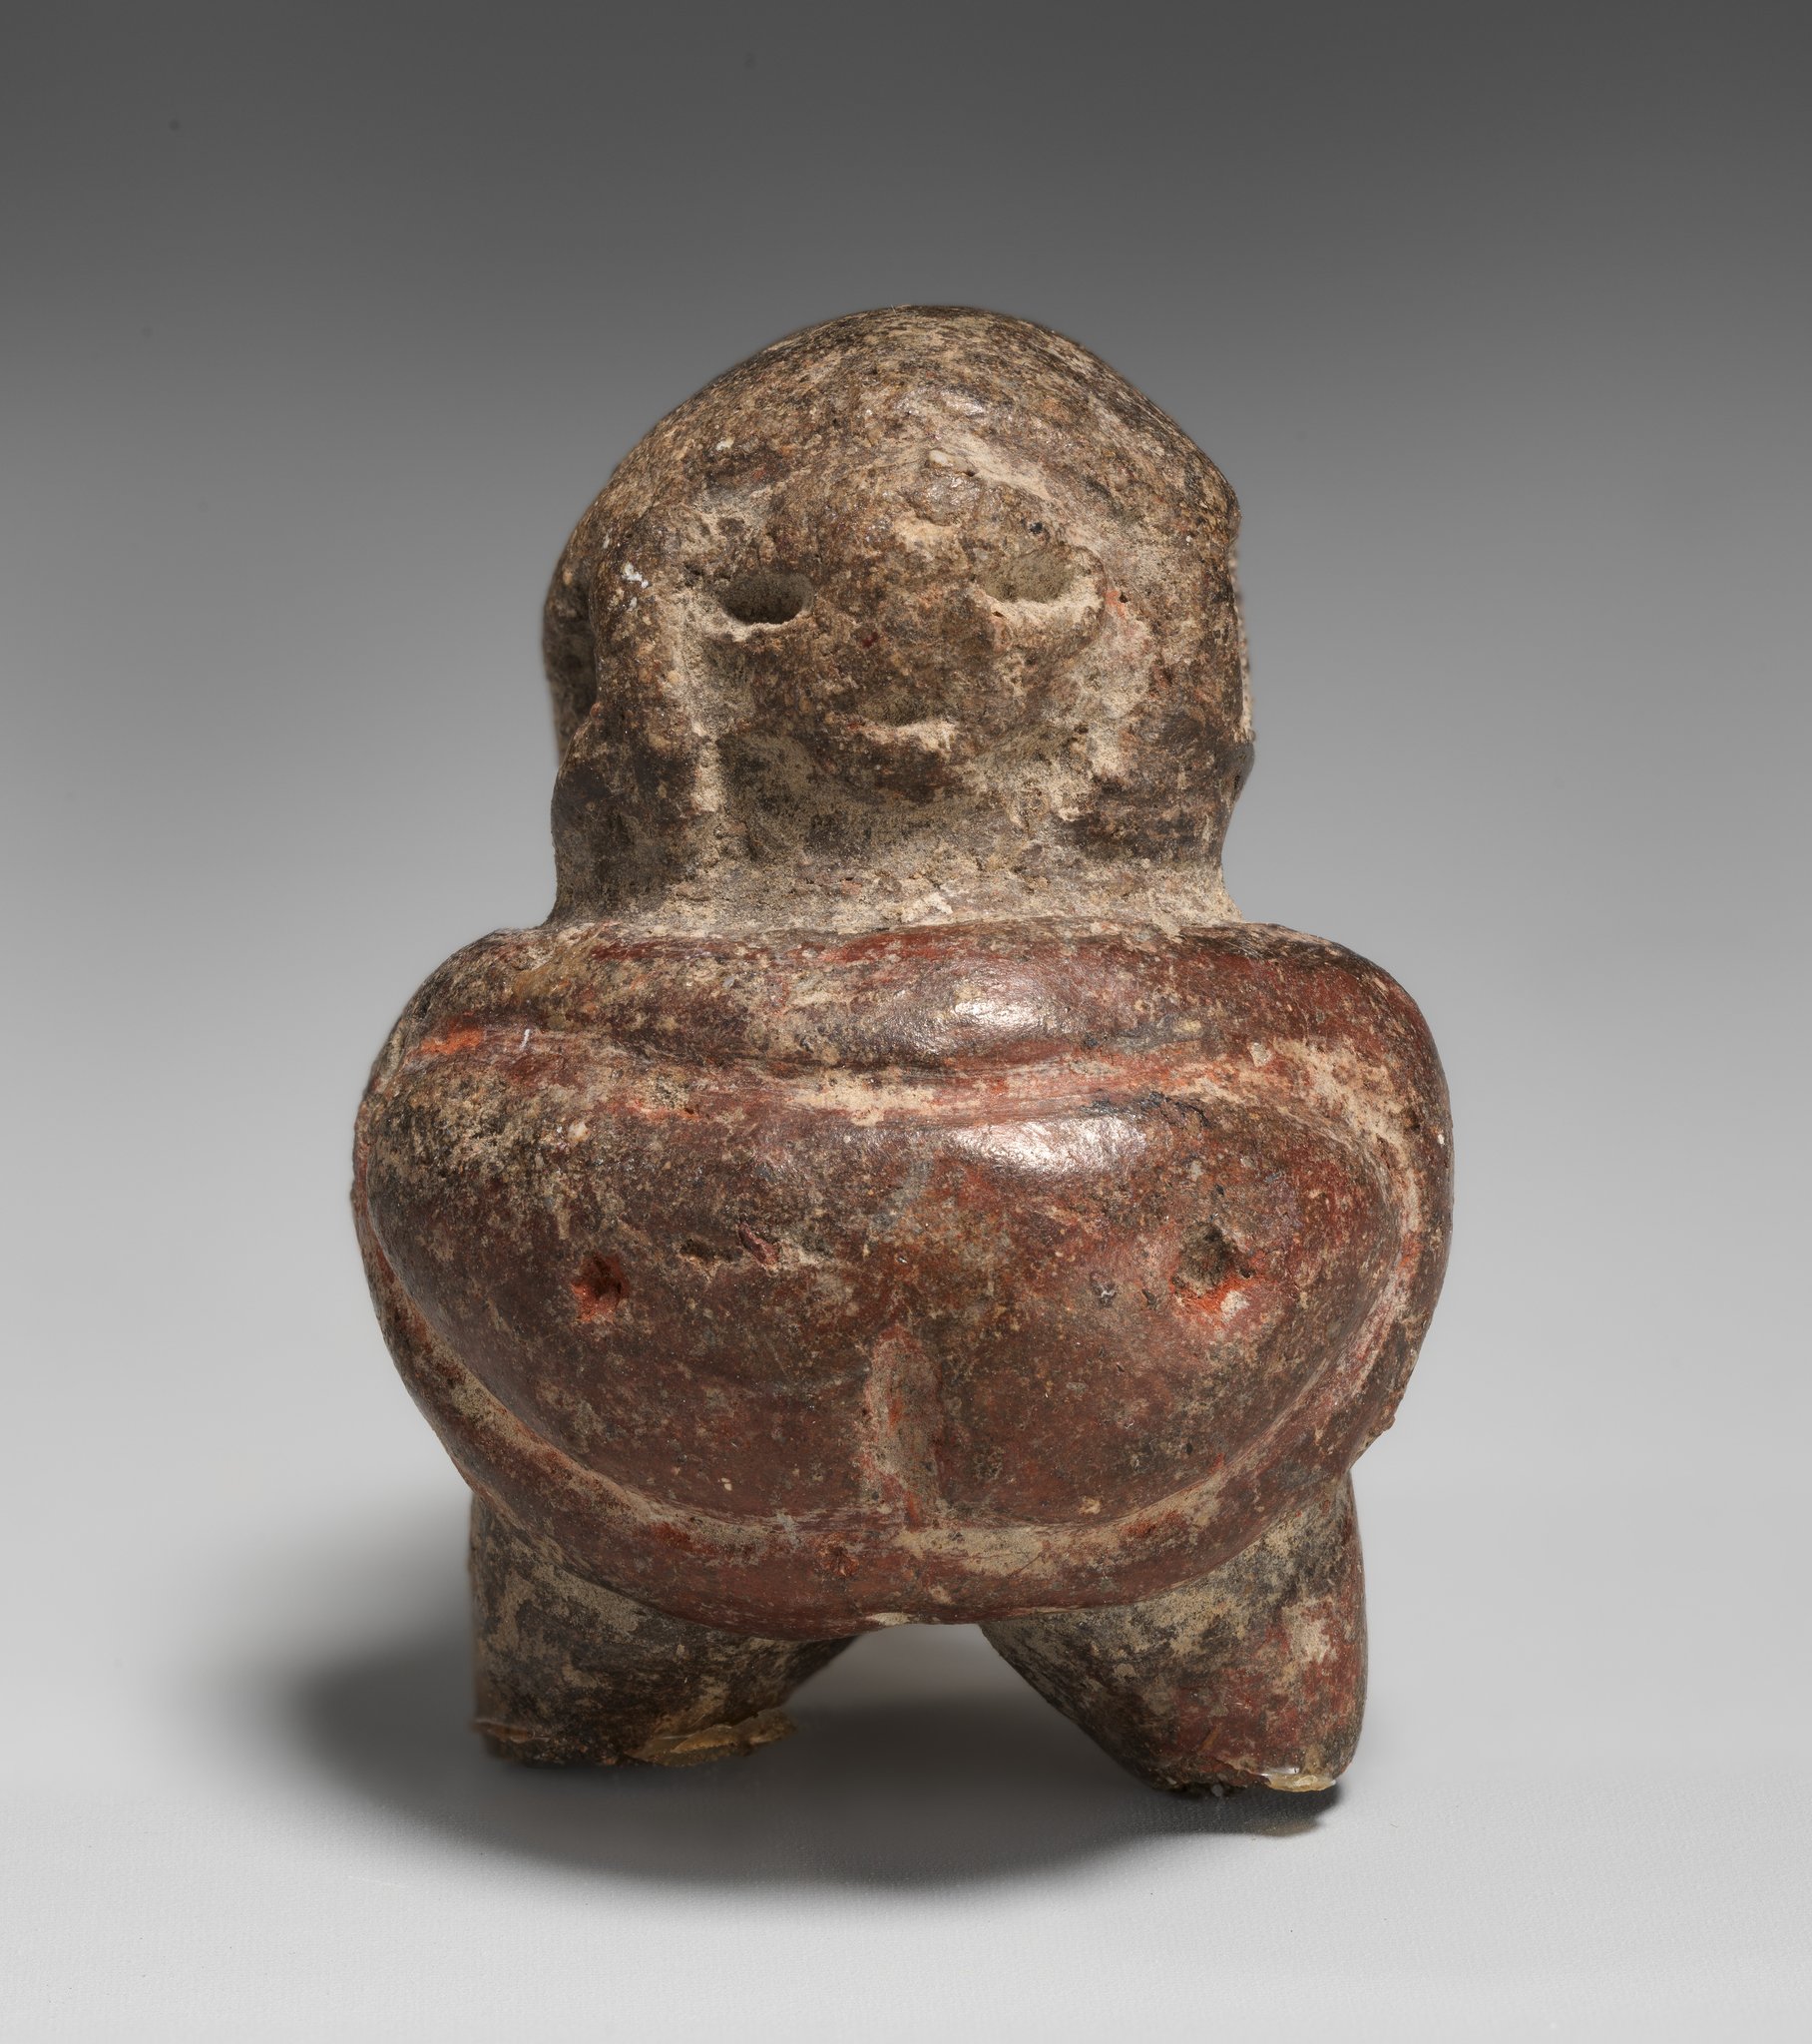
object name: figure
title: Standing Figure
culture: valdivia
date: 3000-1001 BCE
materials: ceramic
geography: ecuador